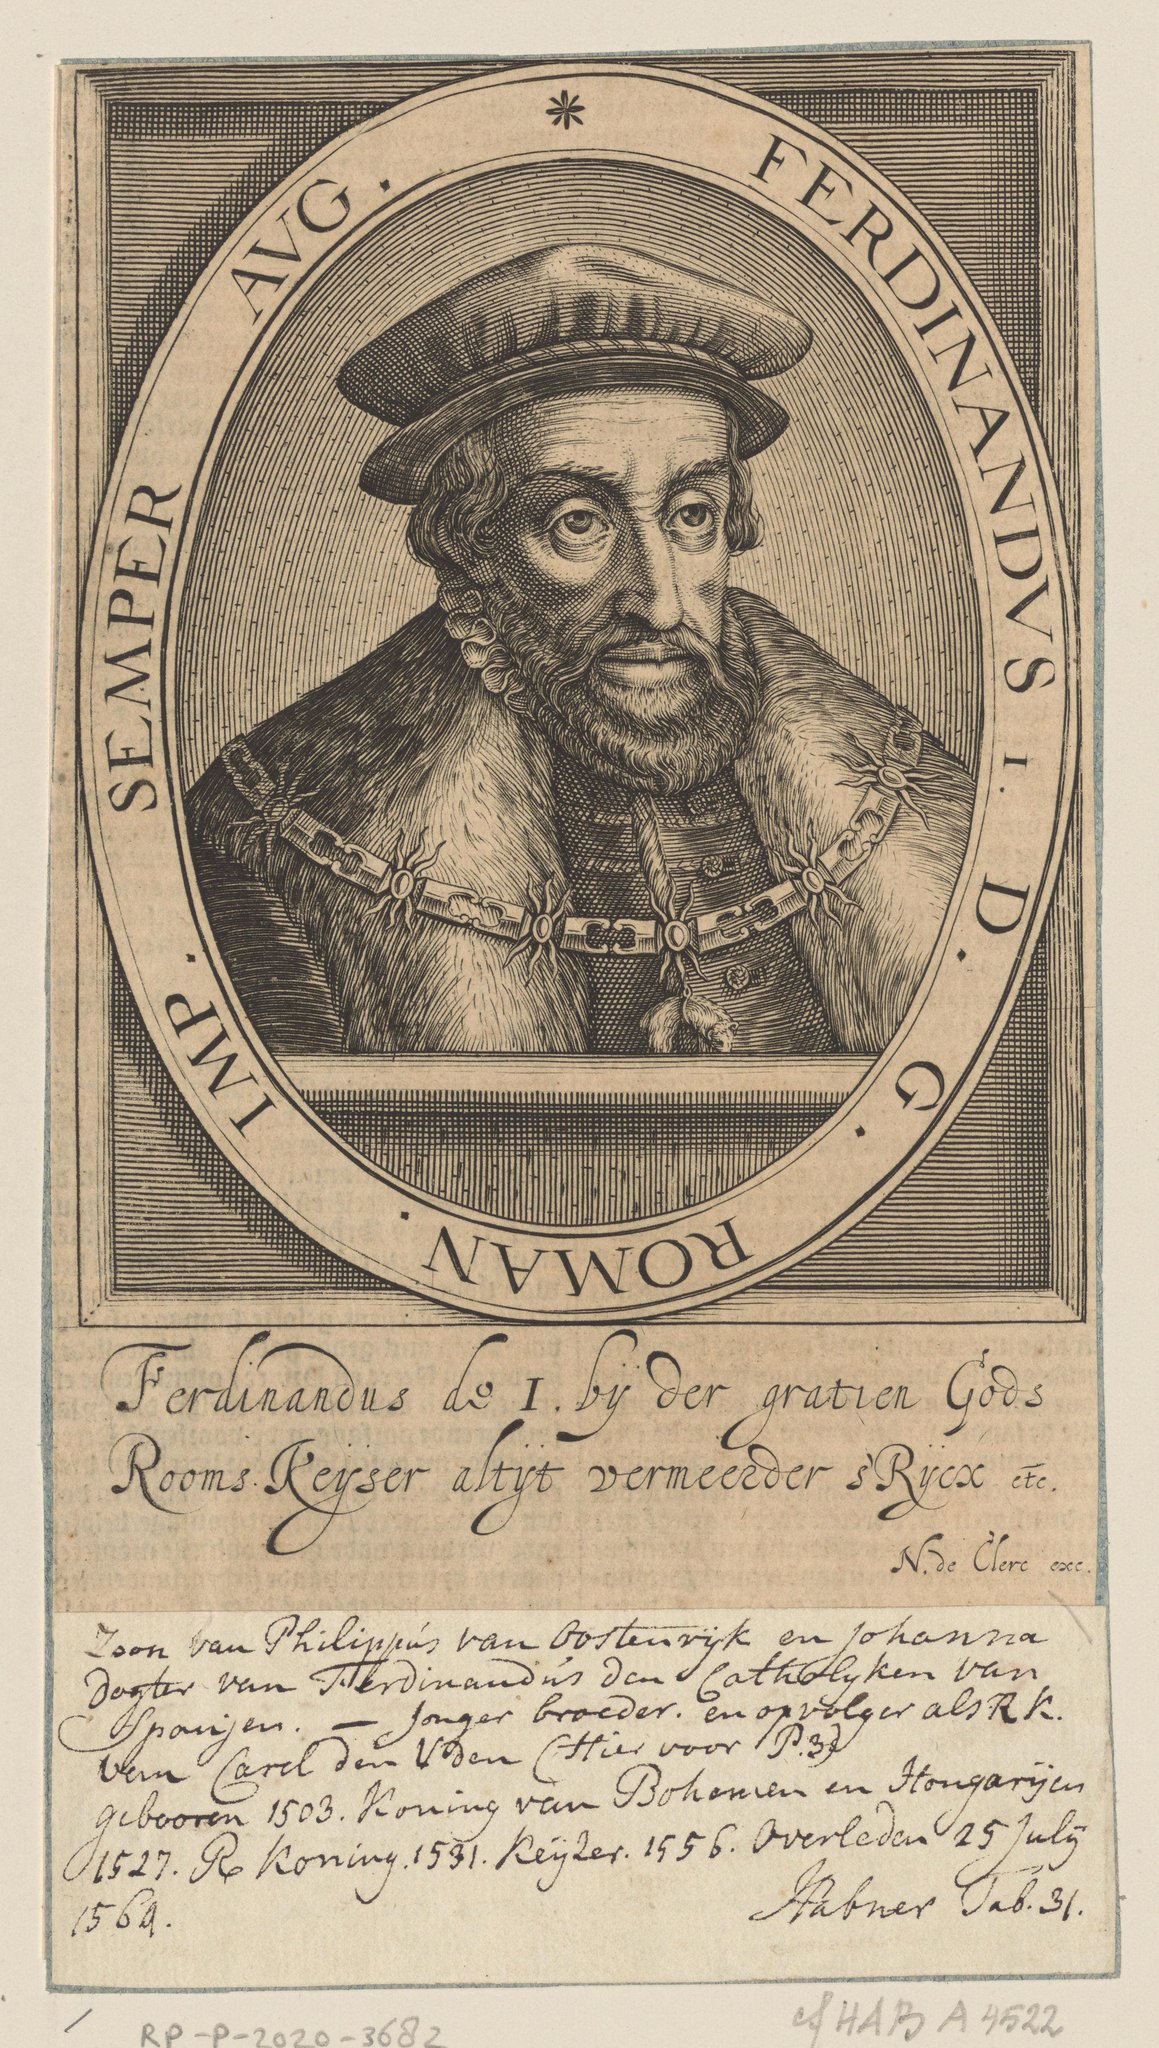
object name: book illustration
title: Portret van keizer Ferdinand I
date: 1610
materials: paper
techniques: engraving, letterpress printing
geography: delft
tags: vienna, ferdinand i van habsburg (duits keizer), historical persons, knighthood order of the golden fleece, emperor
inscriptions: inscription: ‘Zoon van Philippus van Oostenrijk en Johanna/ dogter van Ferdinandus den Catholijken van/ Spanjen. - Jonger broeder en opvolger als R.K./ van Carel den Vden (Hier voor P.3)/ gebooren 1503. Koning van Bohemen en Hongarijen/ 1527. R Koning 1531. Keijzer 1556. Overleden 25 Julij/ 1564. Habner Tab. 31.’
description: Prent uit: Ulloa, Alfonso de. Historie, ende het leven van den aldermachtichsten ende victorieusten Keyser Caerle de vijfde van dien name (...). Delft: Adriaen Gerritsz, 1610.